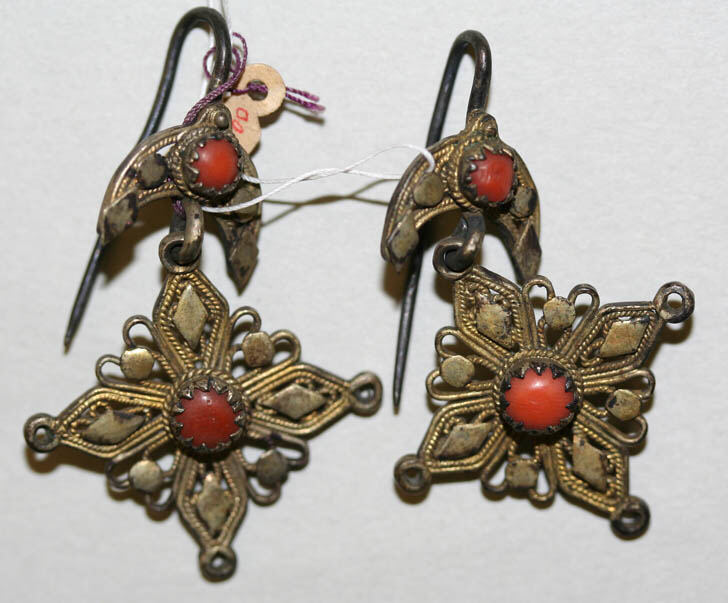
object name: earring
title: Earrings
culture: european, eastern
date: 1701-1900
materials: metal